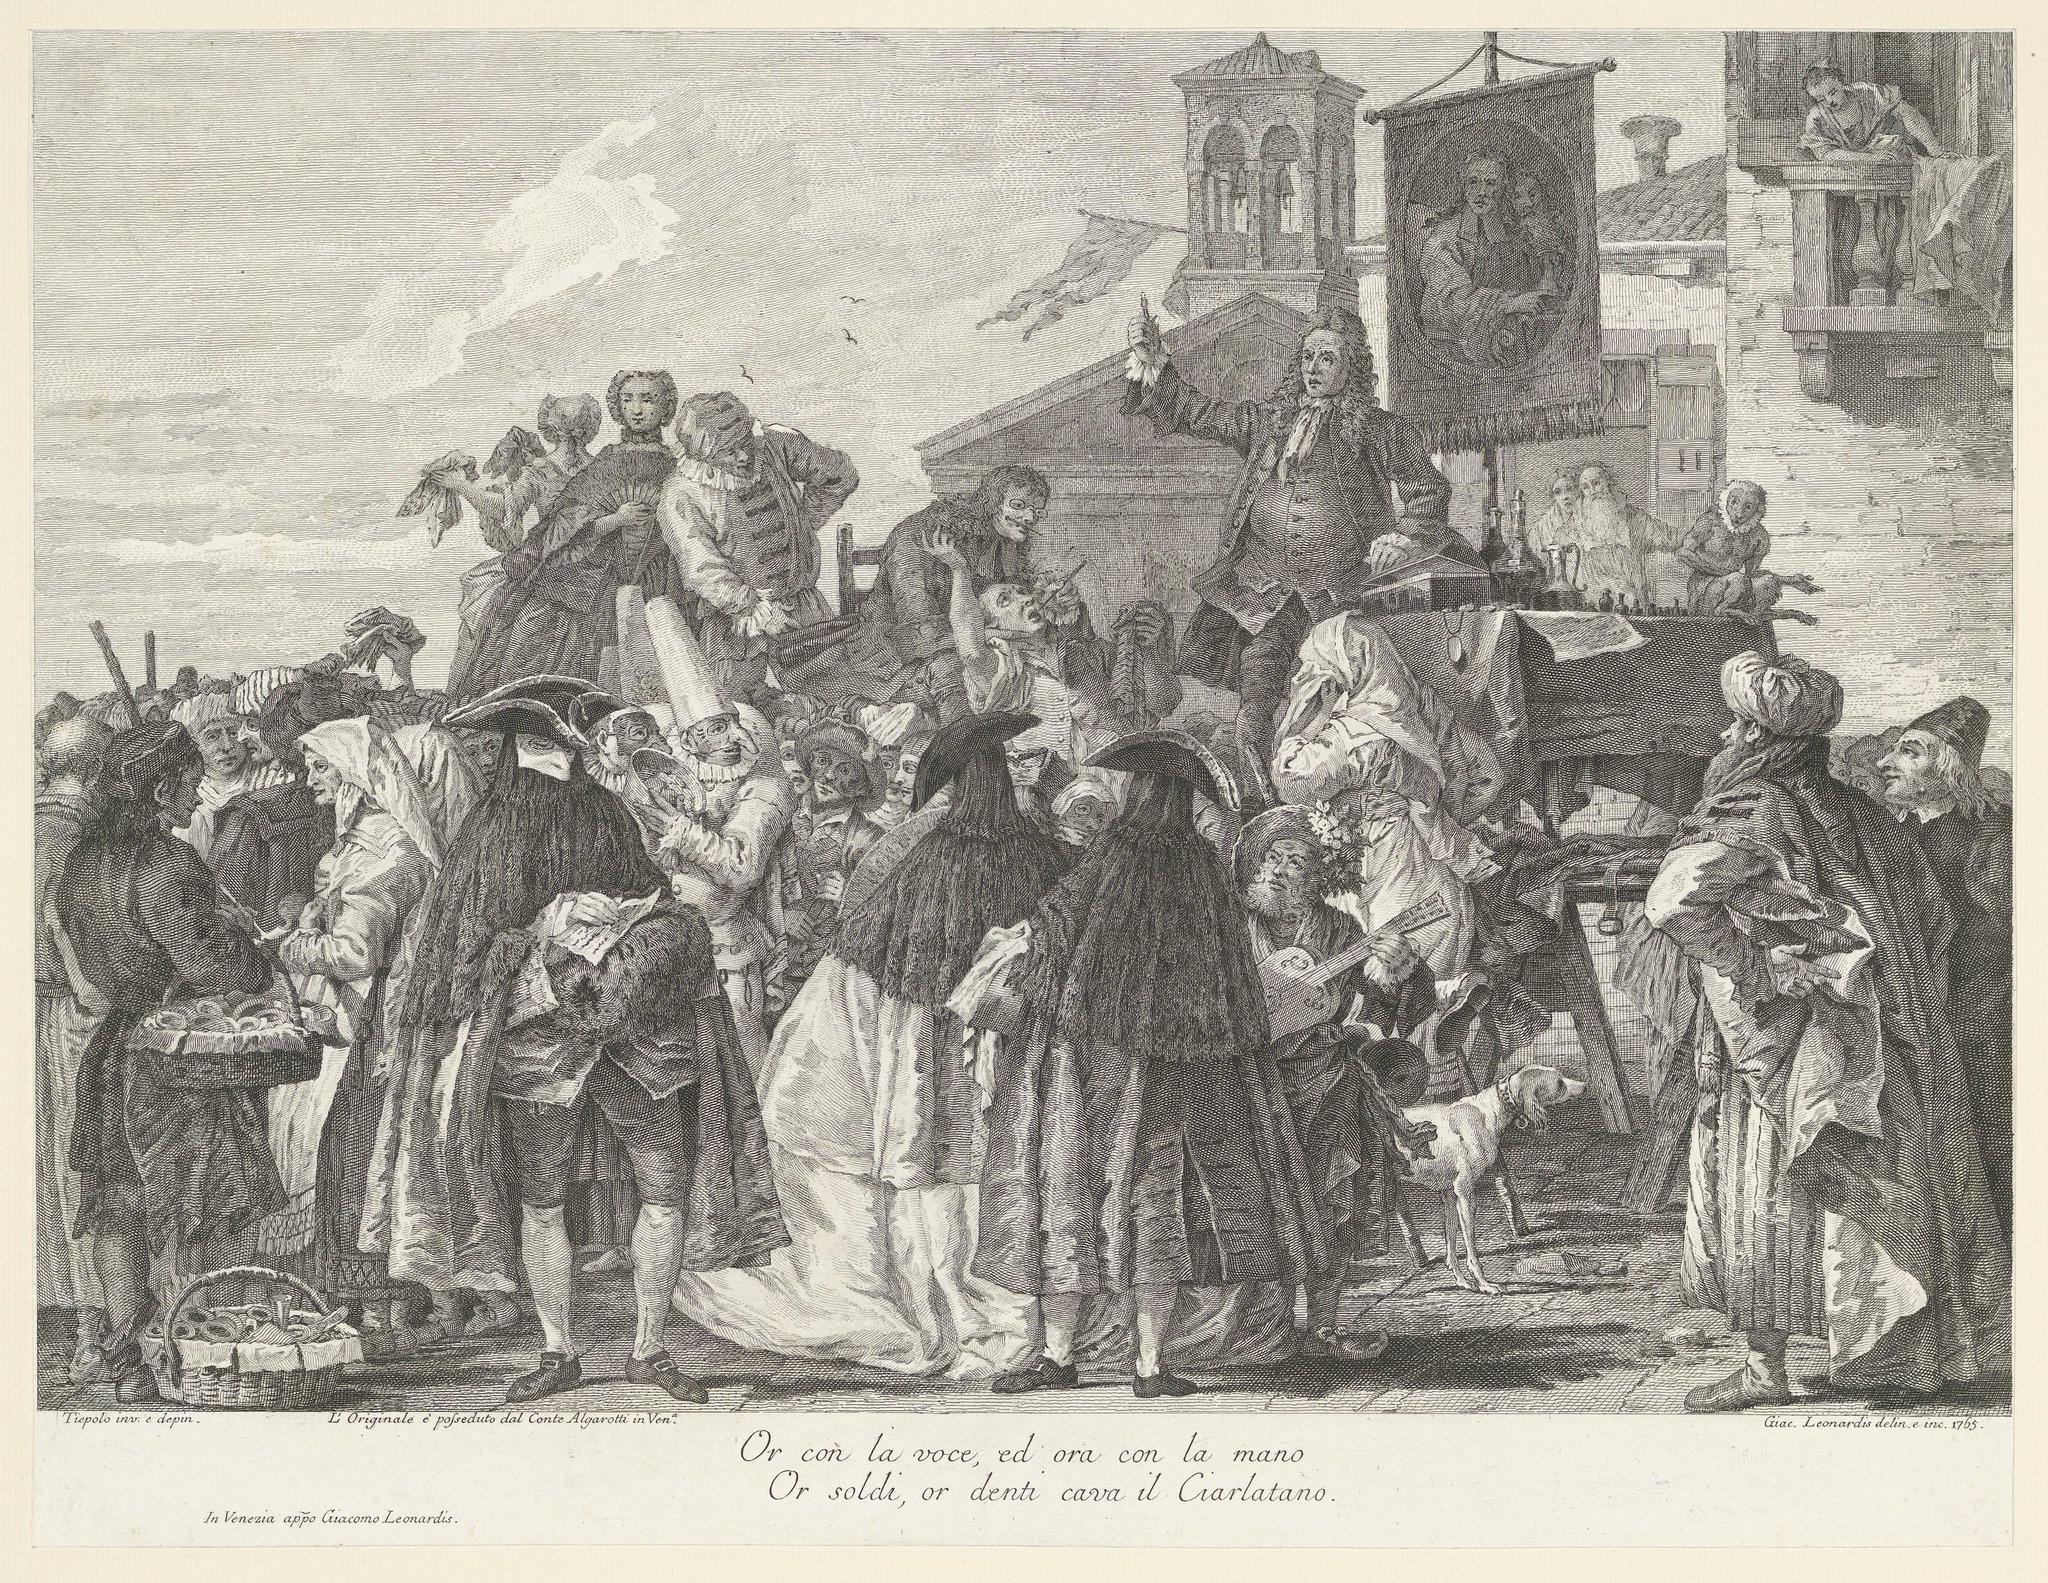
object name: print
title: De kwakzalver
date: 1765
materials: paper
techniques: etching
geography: venice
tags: quack, charlatan, mountebank, 'saltimbanco'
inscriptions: collector's mark: Lugt 2228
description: Een menigte op straat voor een kwakzalver op een podium. Tweeregelig Italiaans vers in ondermarge.